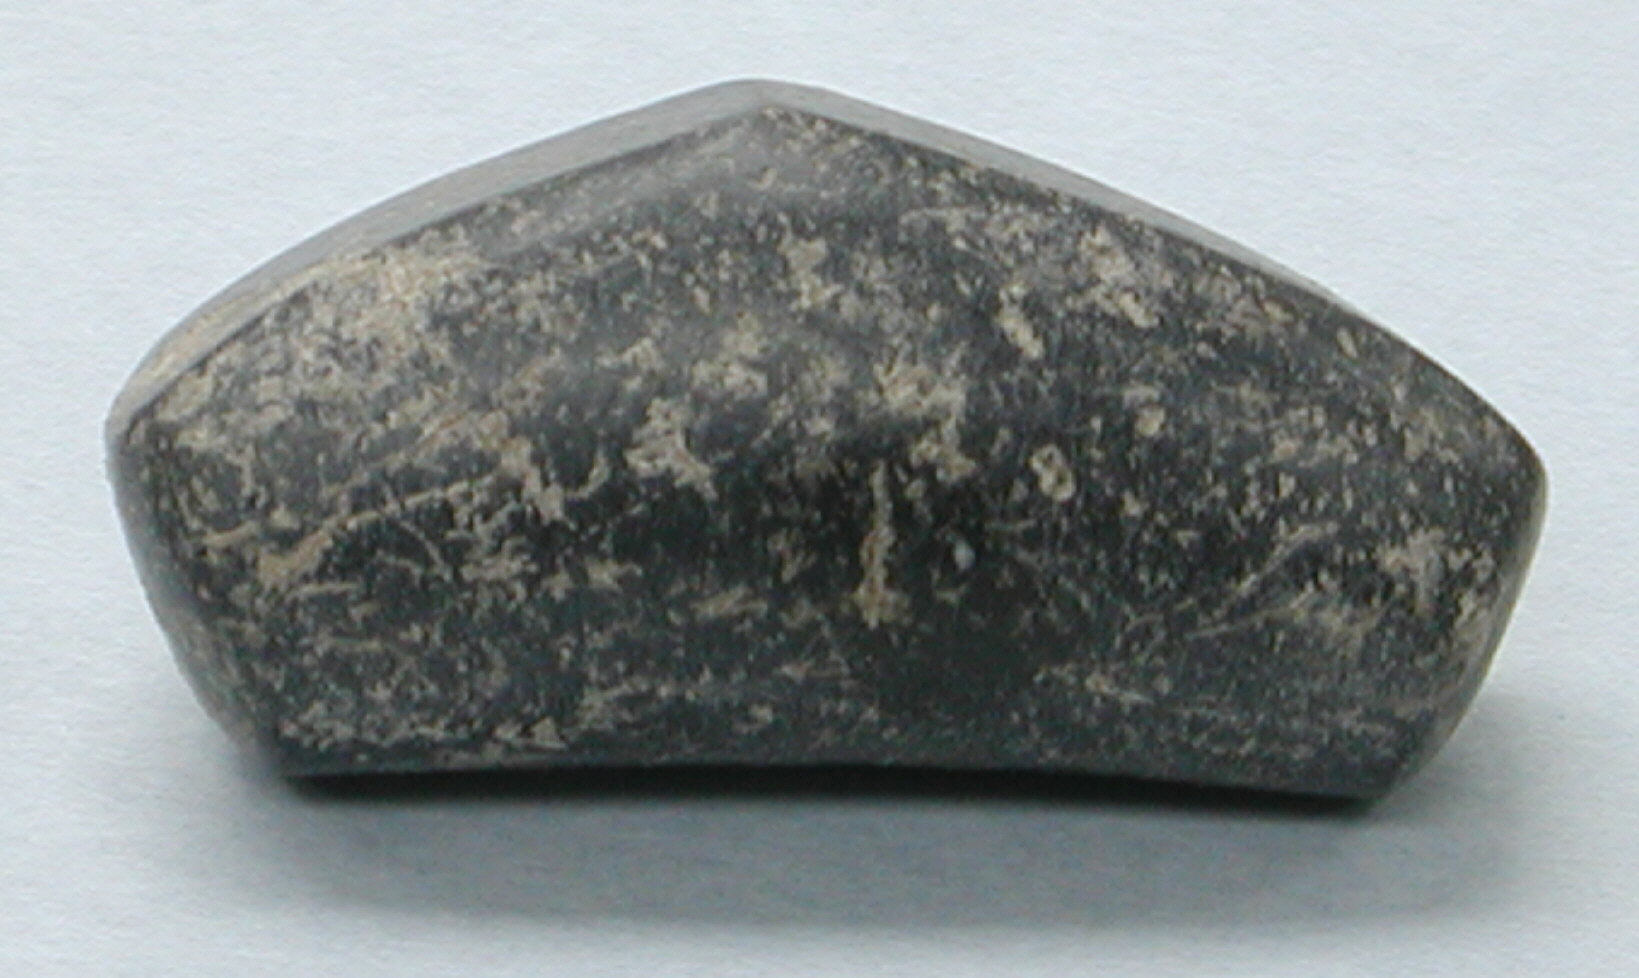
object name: ritual stone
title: Stone Pulidor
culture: mexican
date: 1501-1600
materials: stone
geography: mexico